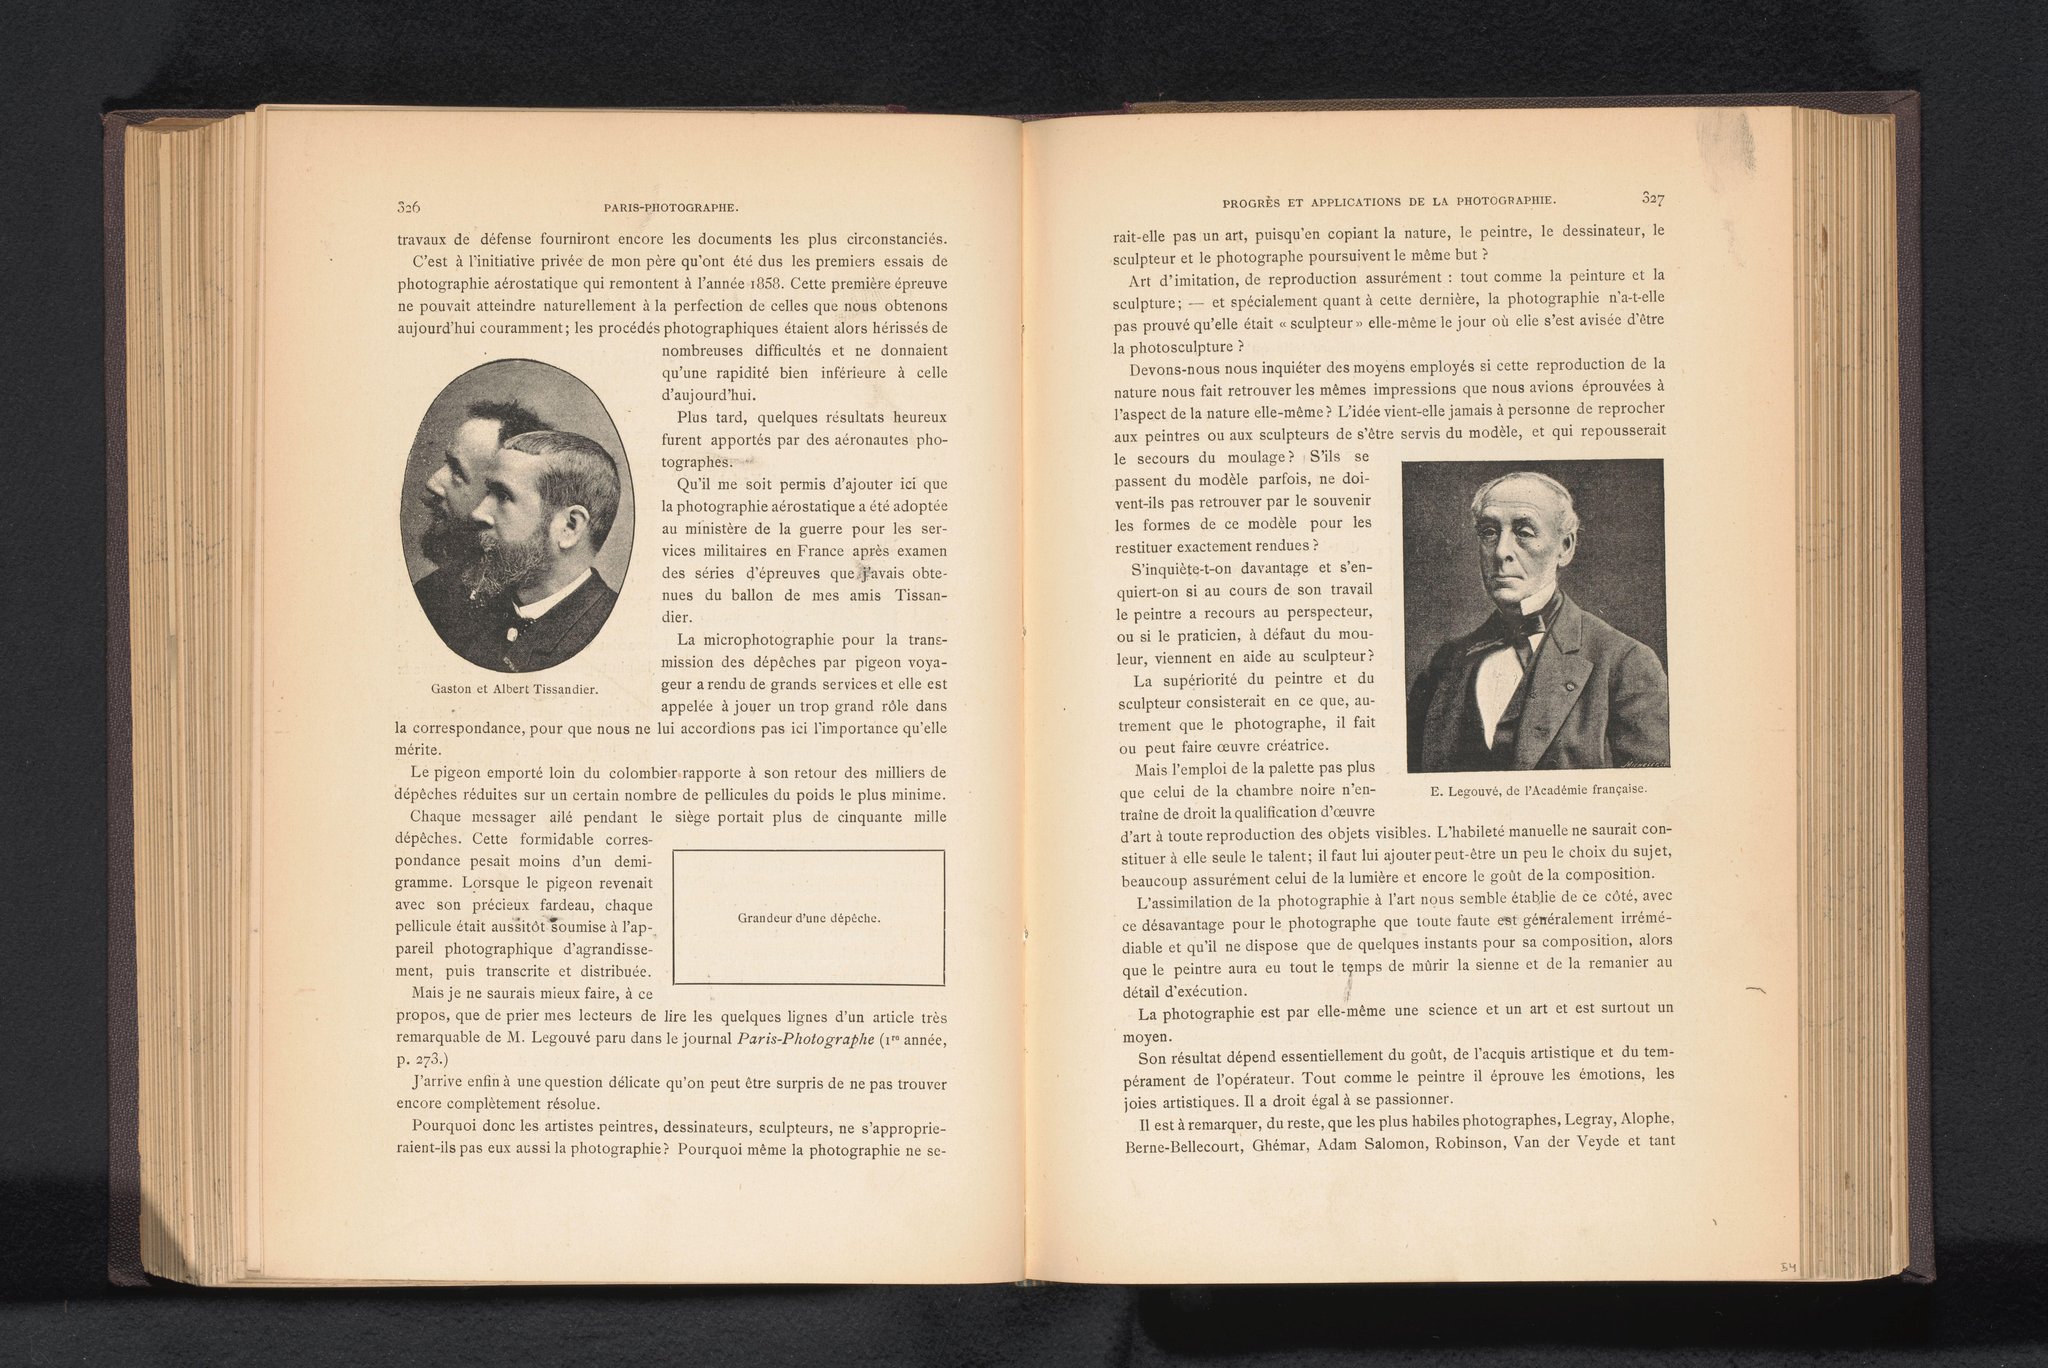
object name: page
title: Portret van Ernest Legouvé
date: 1882-1892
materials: paper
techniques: autotype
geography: france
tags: portrait of a writer